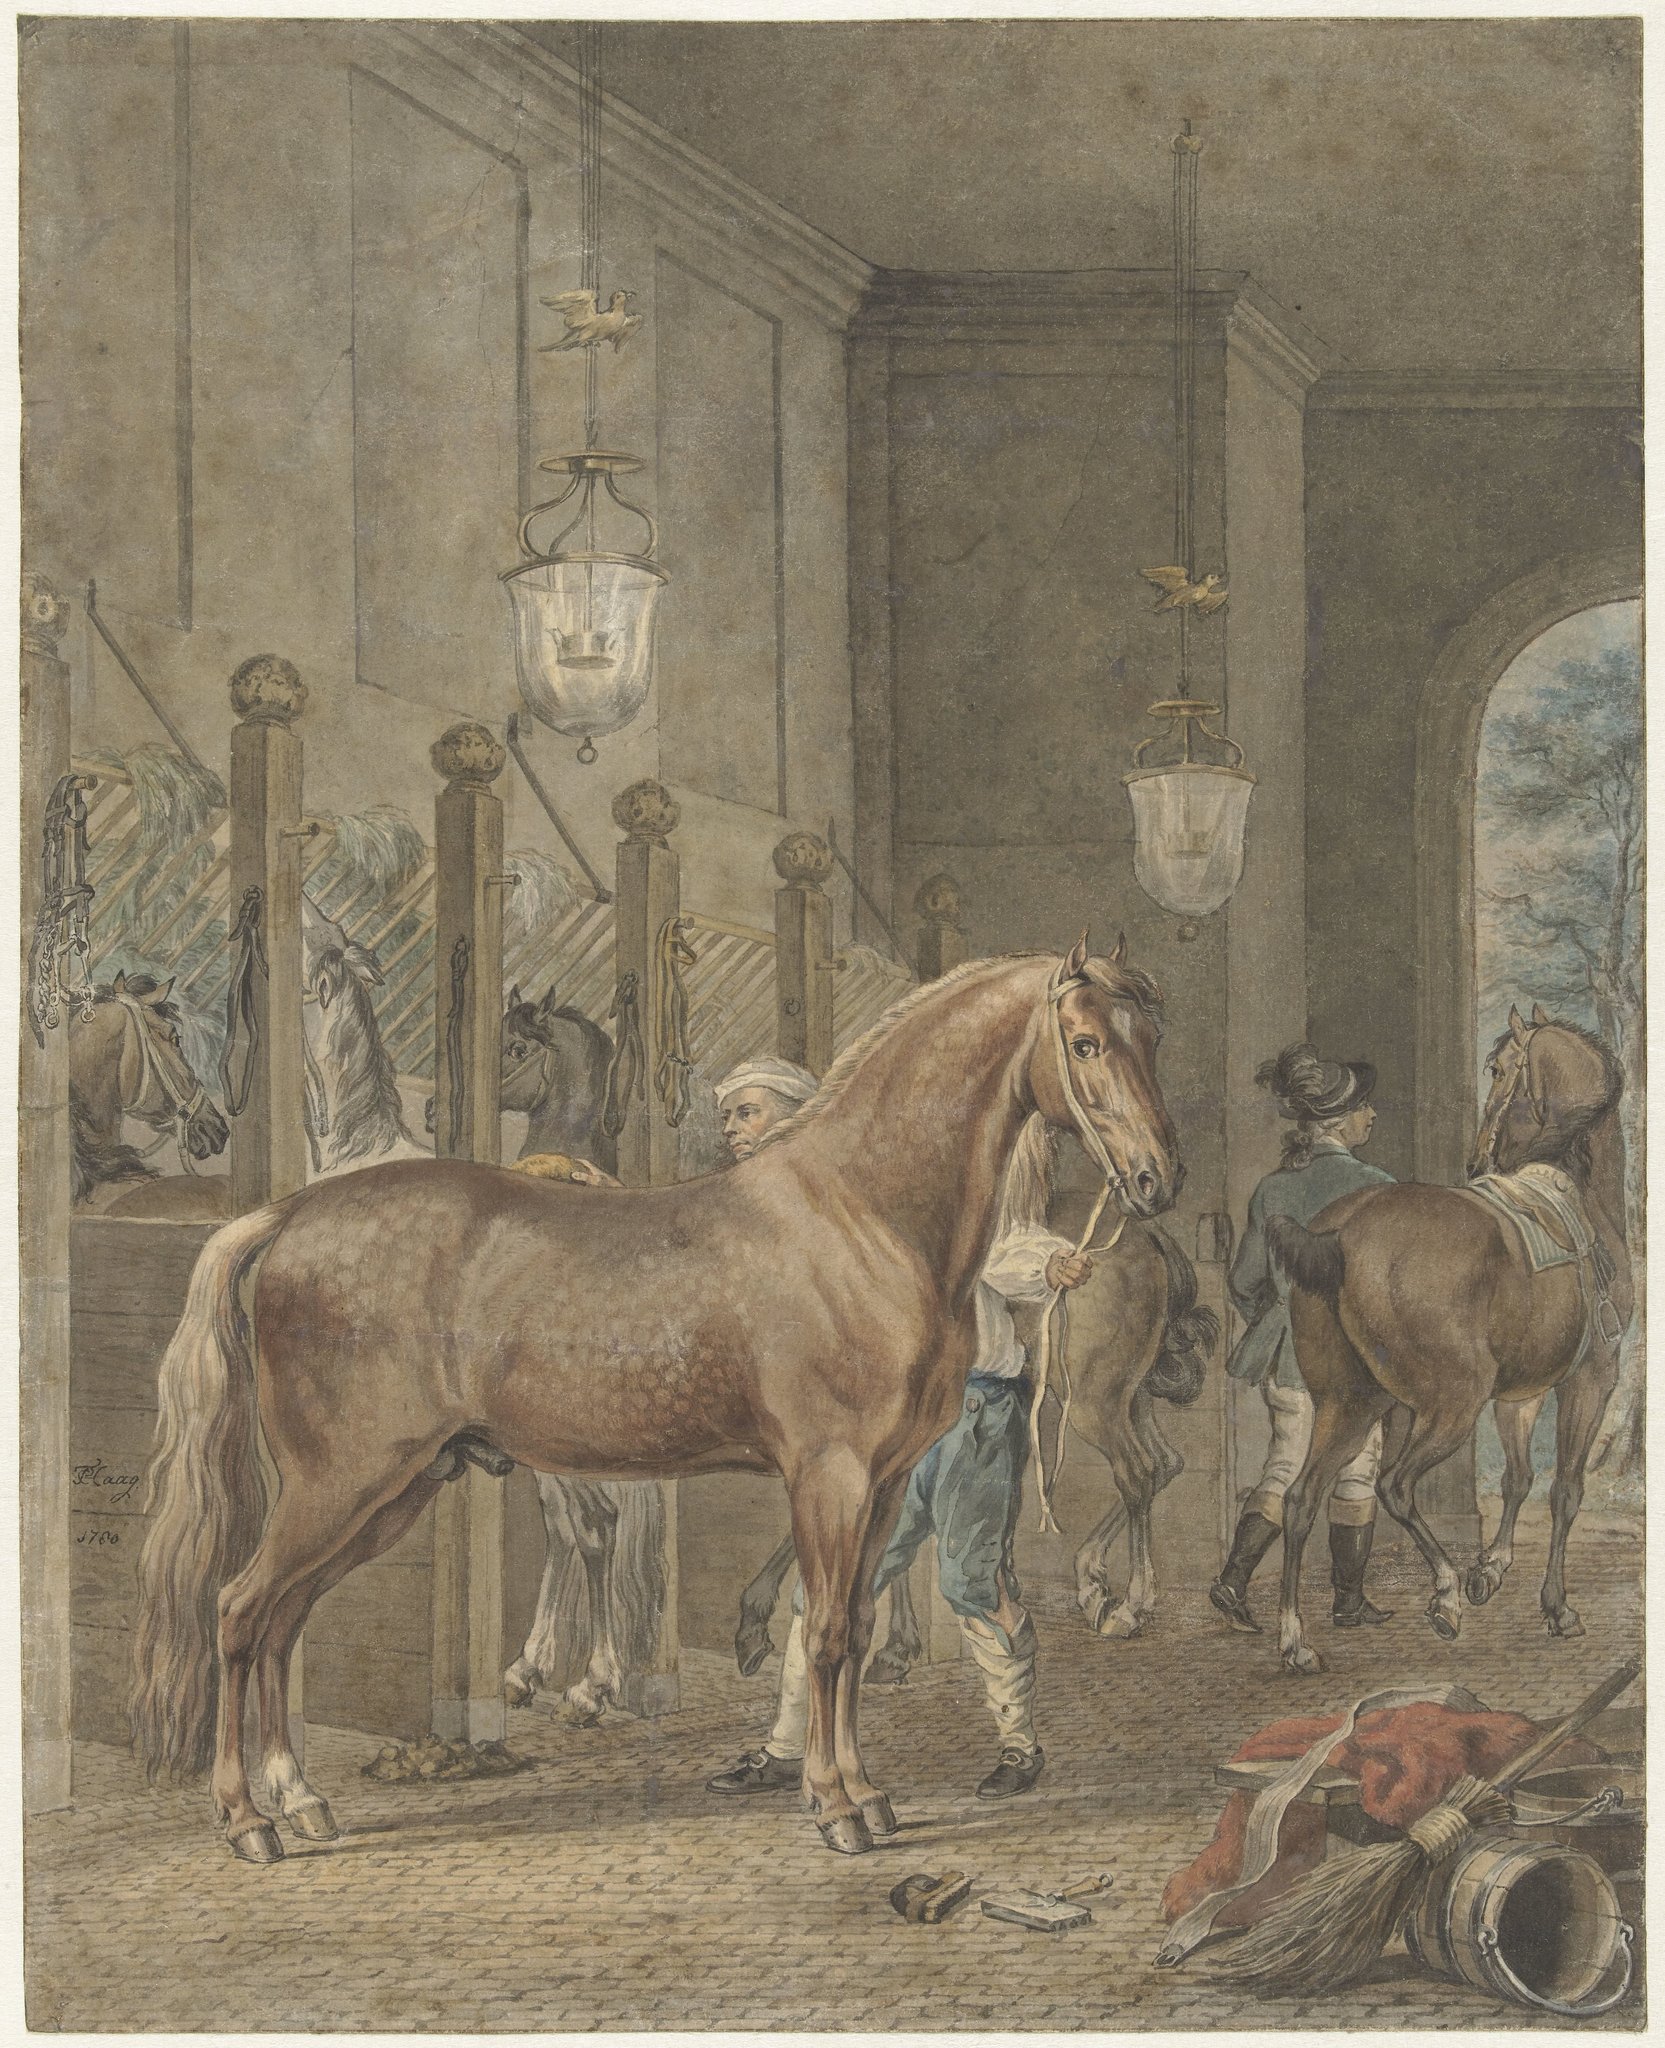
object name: drawing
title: Stable Interior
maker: tethart philip christian haag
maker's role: draughtsman, print maker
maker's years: 1737-1812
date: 1780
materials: ink, paper, watercolor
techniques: brush, pen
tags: horse, stall, stable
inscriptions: title: ‘Deensch paard’, signature and date: ‘TPCHaag/1780’, number: ‘N4032’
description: This heavyset horse of Polish and Spanish bloodlines was bred in the royal stud farm at Frederiksborg Castle in Denmark. The artist drew the animal in the stables of the stadholder’s court in The Hague, where he worked as a portraitist. Ironically, he reaped the most success not with his portraits of people, but with his paintings and drawings of horses – whether or not they included a rider or stable hand.